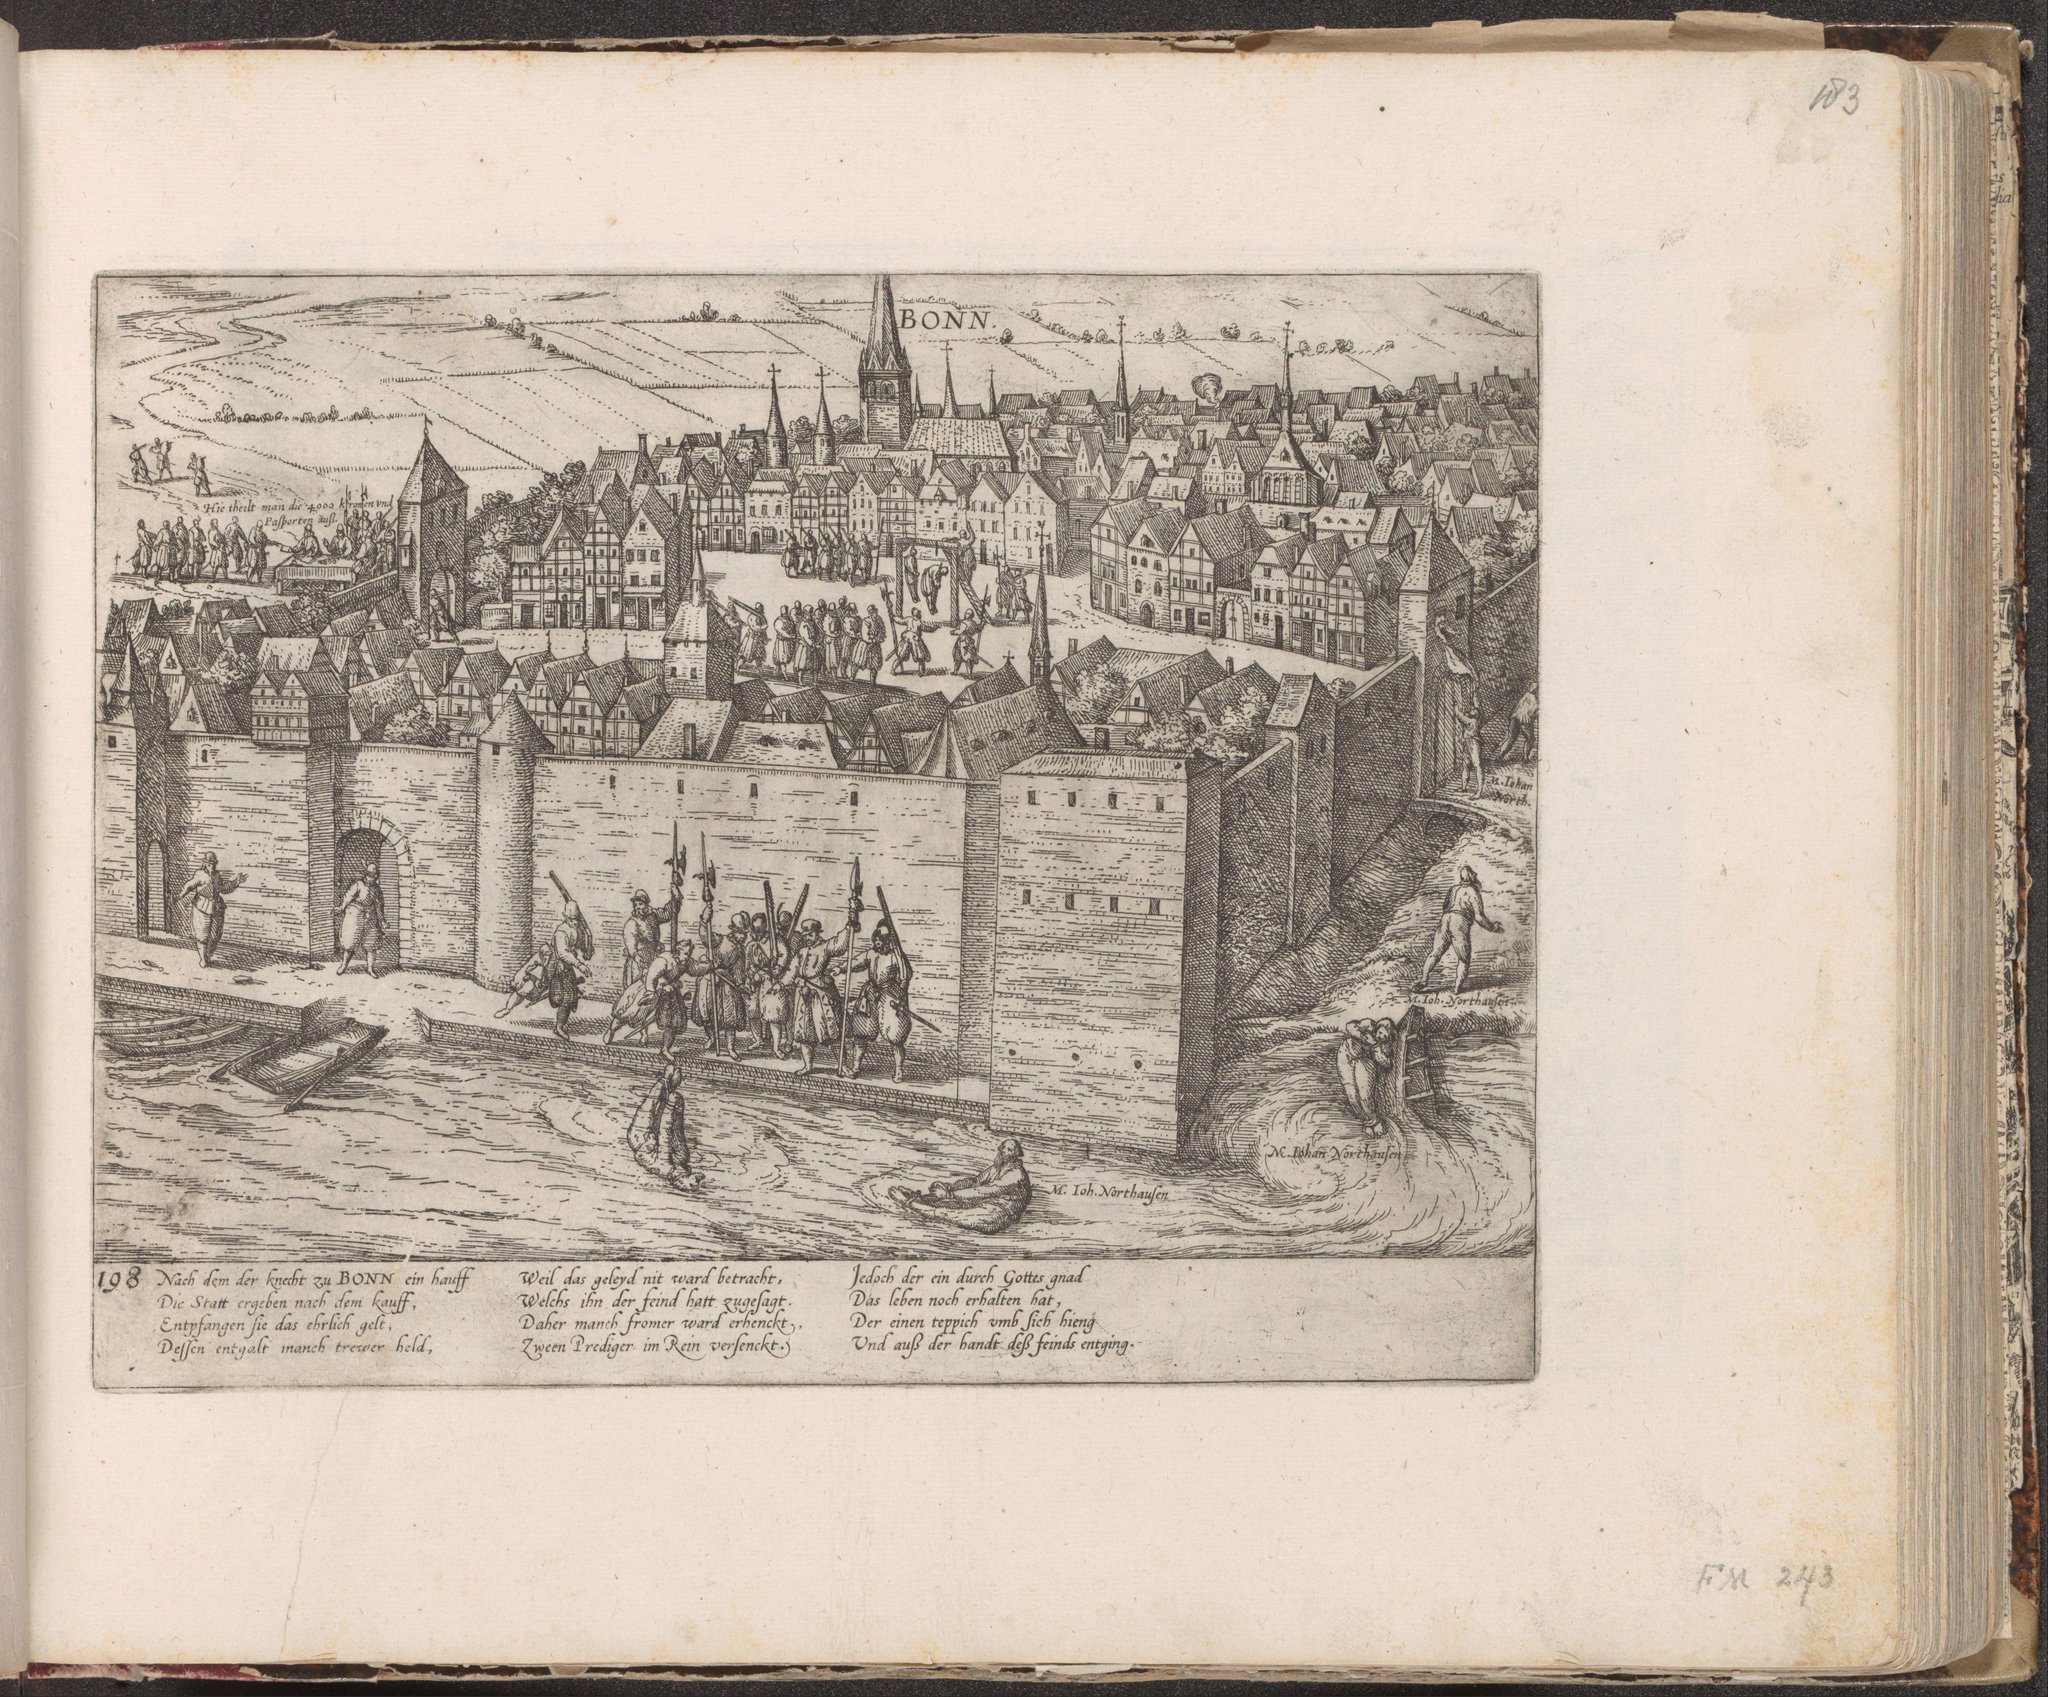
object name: history print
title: Verdrinking van twee predikanten te Bonn, 1584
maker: frans hogenberg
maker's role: print maker, publisher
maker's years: 1538-1590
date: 1587-1591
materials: paper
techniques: etching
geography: cologne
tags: violent death, being killed; being mishandled and maltreated; seeking death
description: Verdrinking van twee predikanten te Bonn, 6 februari 1584. Buiten de stadsmuren worden twee predikanten geboeid in de Rijn gegooid, één van deze, Johan Northausen, overleeft. Op een plein in de stad executies door ophanging. Episode uit de Keulse Oorlog. Linksonder genummerd: 198. De prent maakt deel uit van een album.